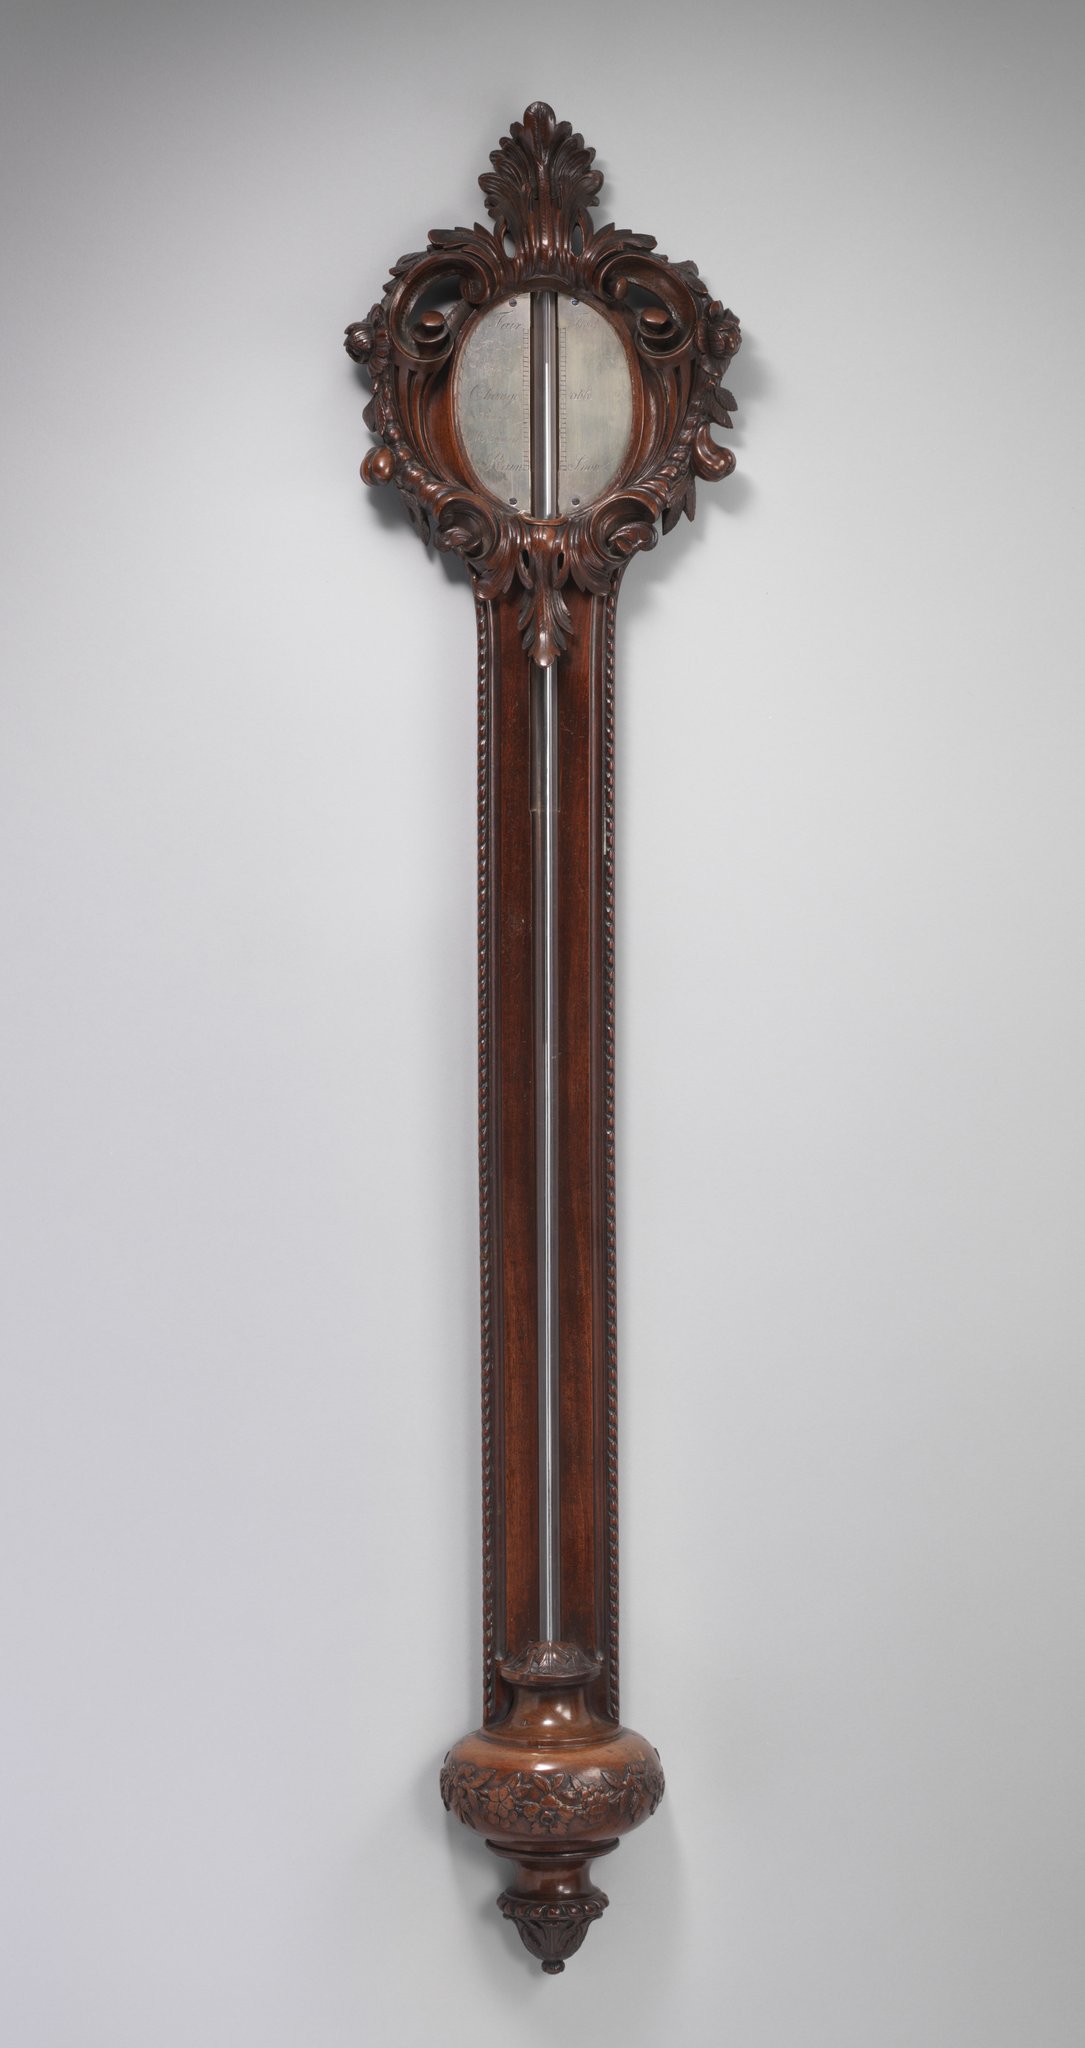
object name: torricellian barometer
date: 1760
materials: wood, mercury